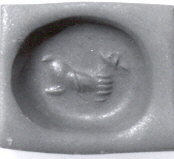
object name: stamp seal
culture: sasanian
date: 201-700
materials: mineral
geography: iran or mesopotamia